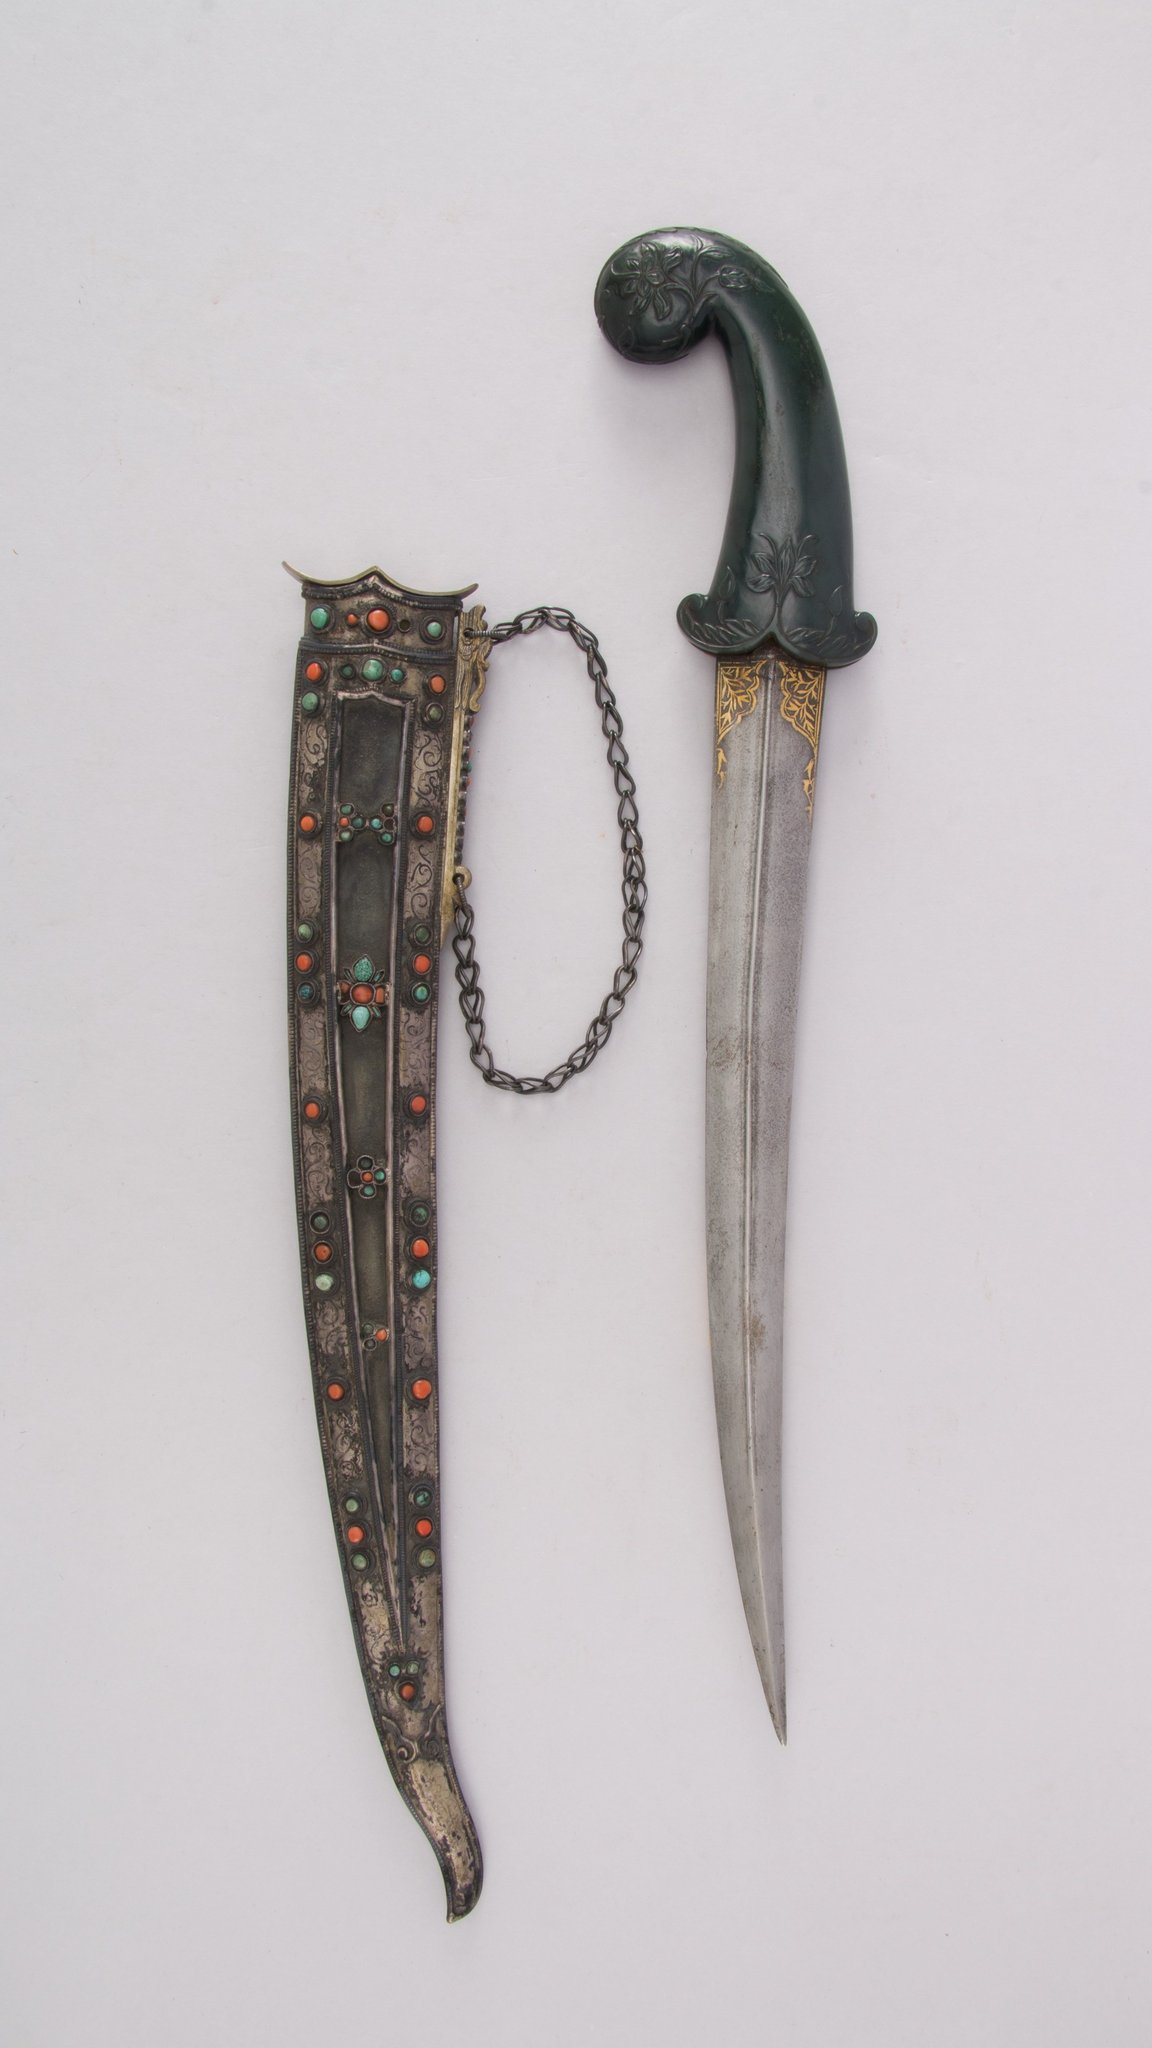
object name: dagger with sheath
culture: indian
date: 1801-1900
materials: coral, gold, jade, leather, silver, steel, wood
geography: india